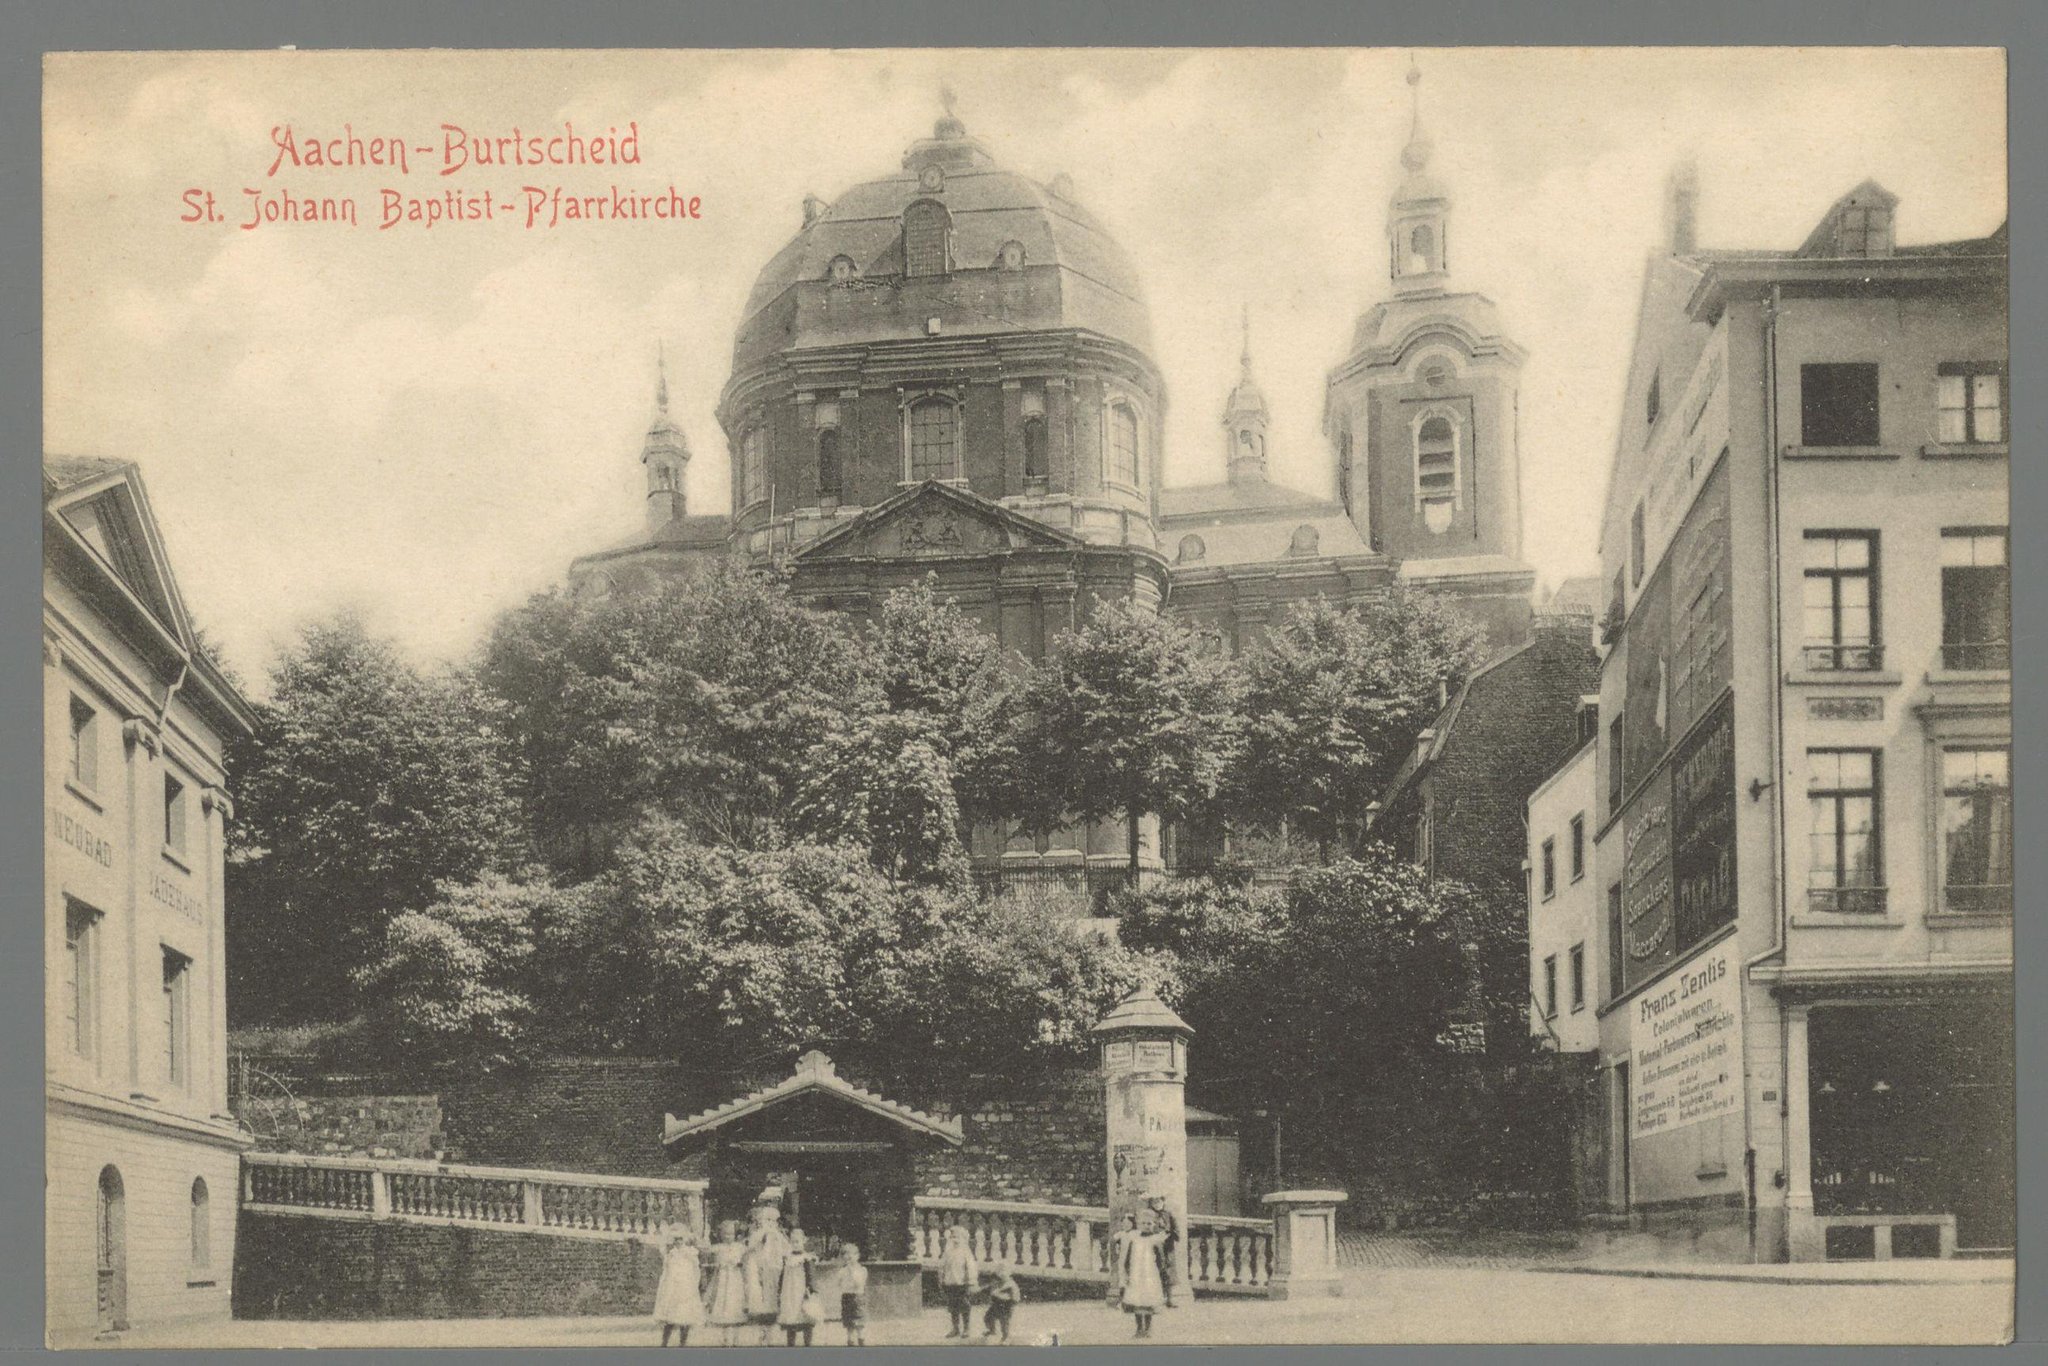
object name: ansichtkaart, prentbriefkaart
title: Aachen-Burtscheid. St. Johann Baptist-Pfarrkirche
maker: Anonymous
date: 1905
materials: cardboard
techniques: photograph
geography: dresden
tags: church (exterior)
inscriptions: date